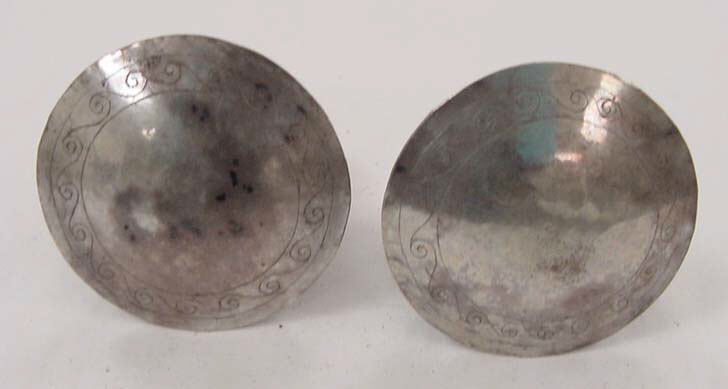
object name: ear ornament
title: Ear ornaments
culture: indigenous american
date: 1100-1459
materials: silver